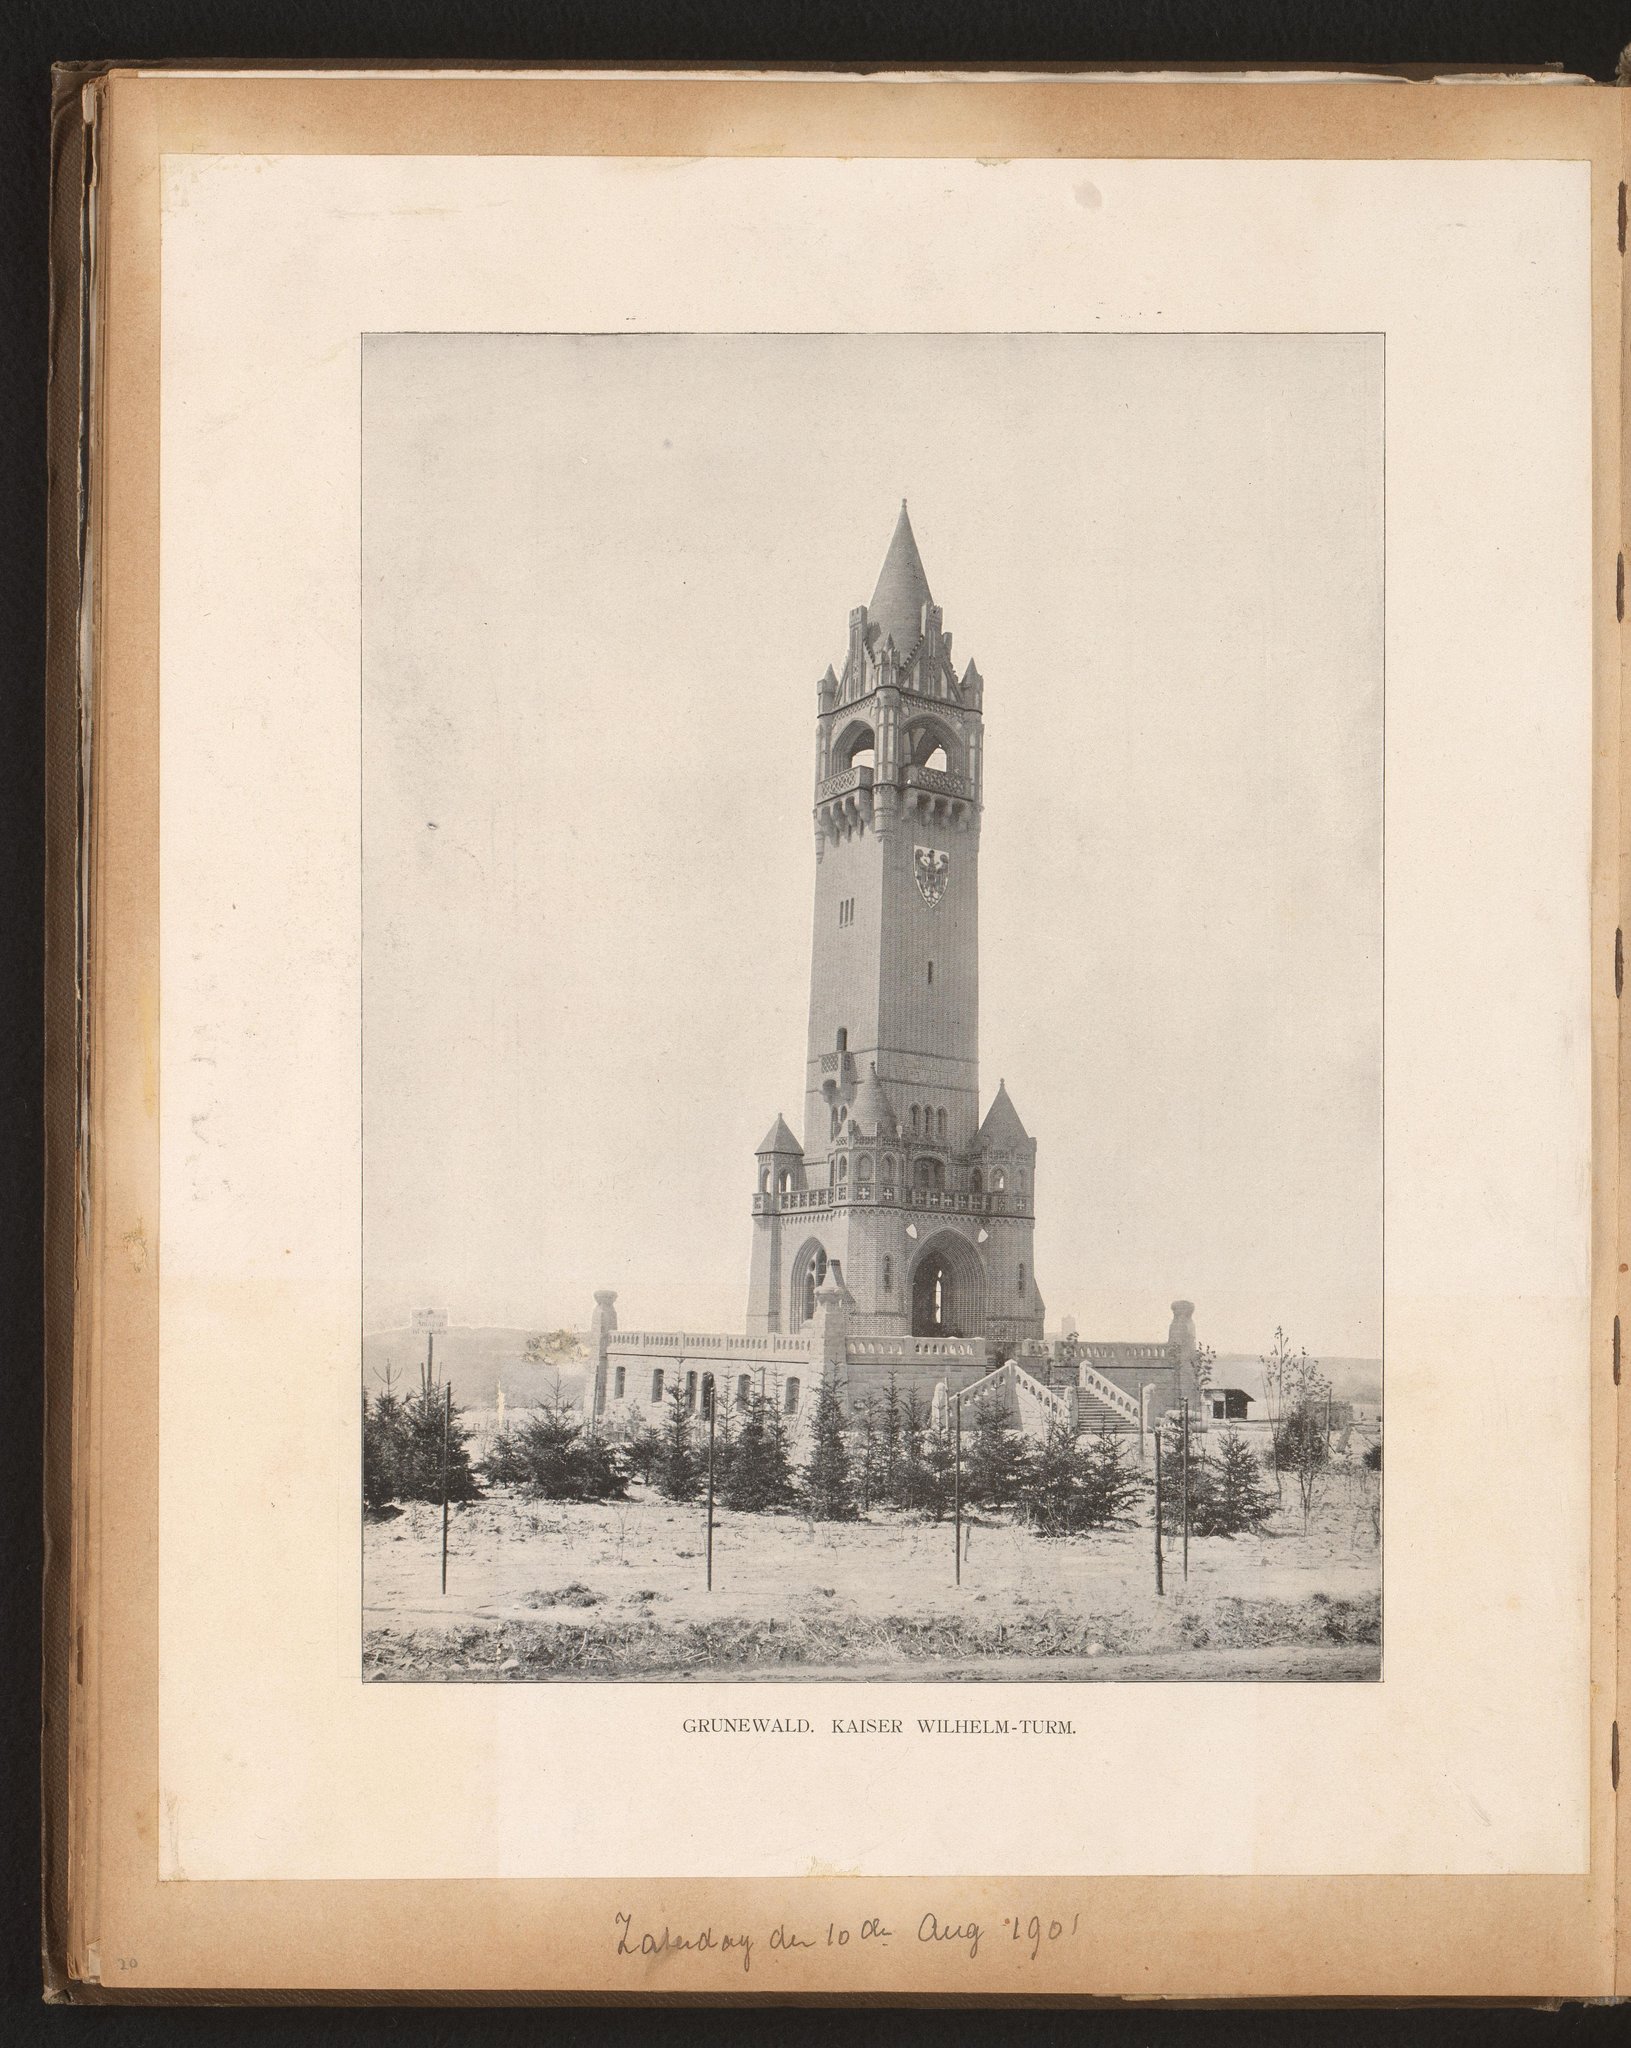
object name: photomechanical print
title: Toren ter nagedachtenis aan keizer Wilhelm I, Grunewald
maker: Anonymous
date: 1899-1901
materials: paper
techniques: autotype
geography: grunewald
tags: tower, clock tower ~ monumental adornment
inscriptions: title: ‘Grunewald. Kaiser Wilhelm-Turm’, inscription: ‘Zaterdag den 10de Aug 1901’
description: Deze fotomechanische afdruk maakt deel uit van een album.